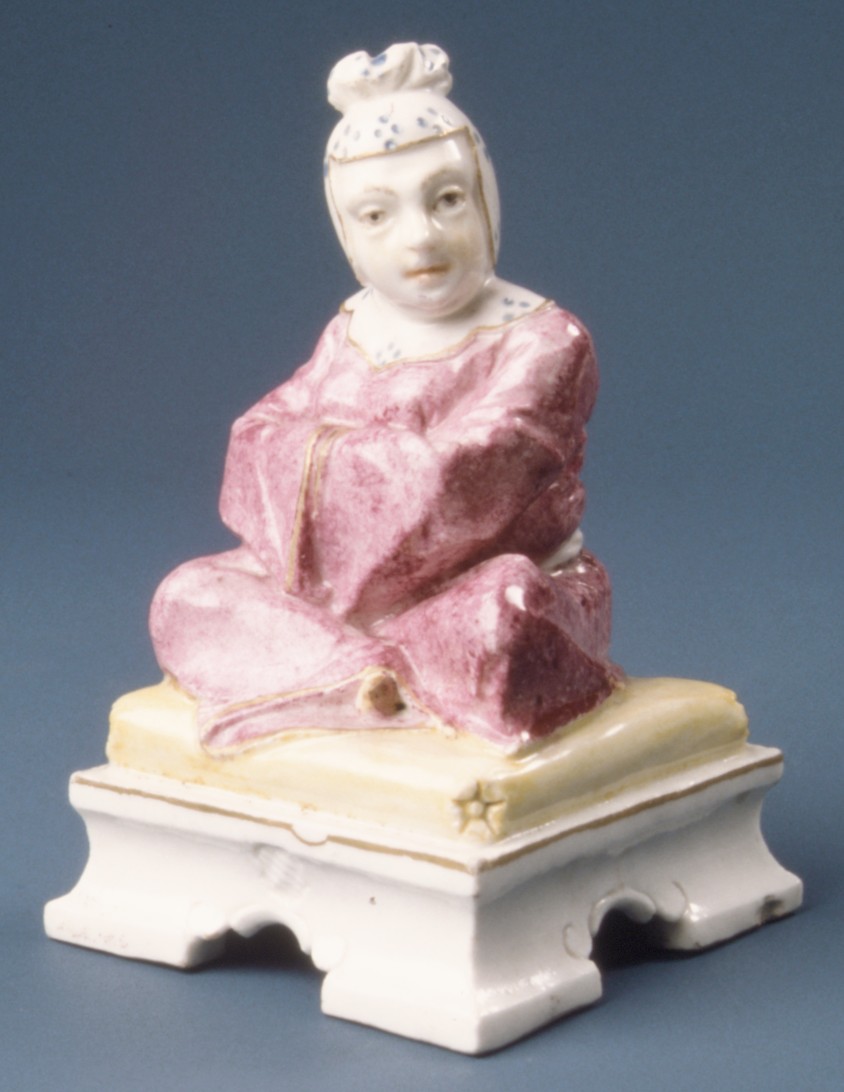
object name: figure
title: Figure of a seated Chinese woman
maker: nymphenburg porcelain manufactory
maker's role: manufactory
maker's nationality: german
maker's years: 1747-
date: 1760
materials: hard paste porcelain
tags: women